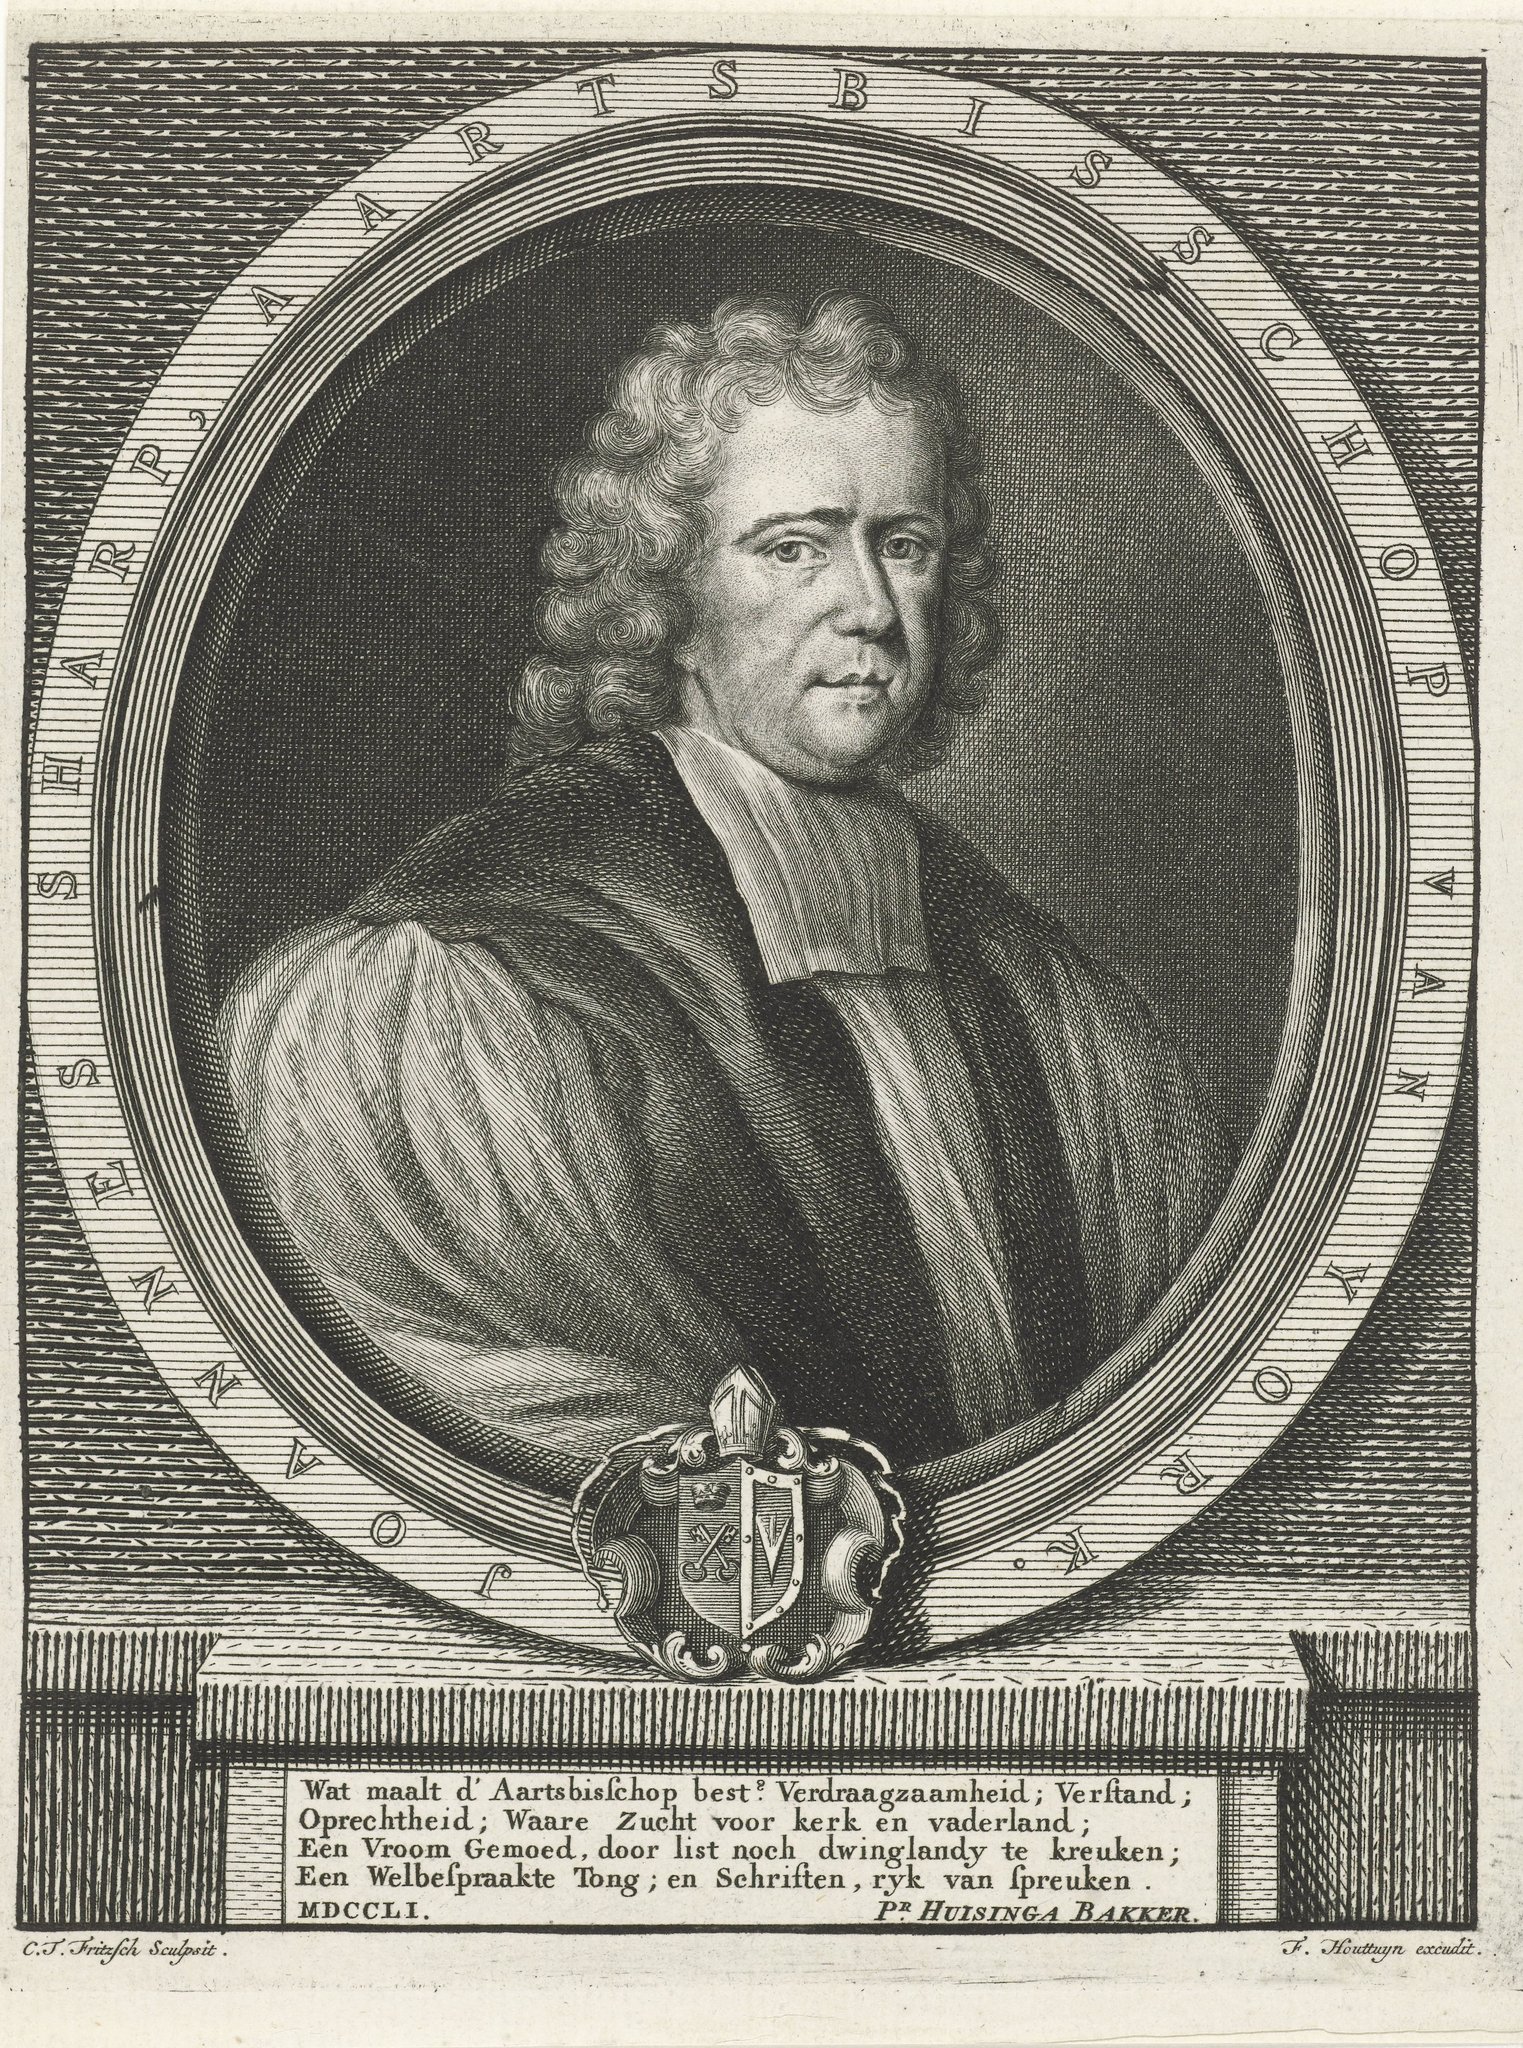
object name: print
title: Portret van John Sharp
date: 1745-1765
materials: paper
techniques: engraving, etching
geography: amsterdam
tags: bradford, aartsbisschop, john sharp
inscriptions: collector's mark: Lugt 2228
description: Portretbuste in ovaal naar rechts van John Sharp, aartsbisschop van York. In het randschrift rond het ovaal staan zijn naam en titel, onderaan een wapen in cartouche. Onder het ovaal staat op een sokkel een vierregelige tekst.